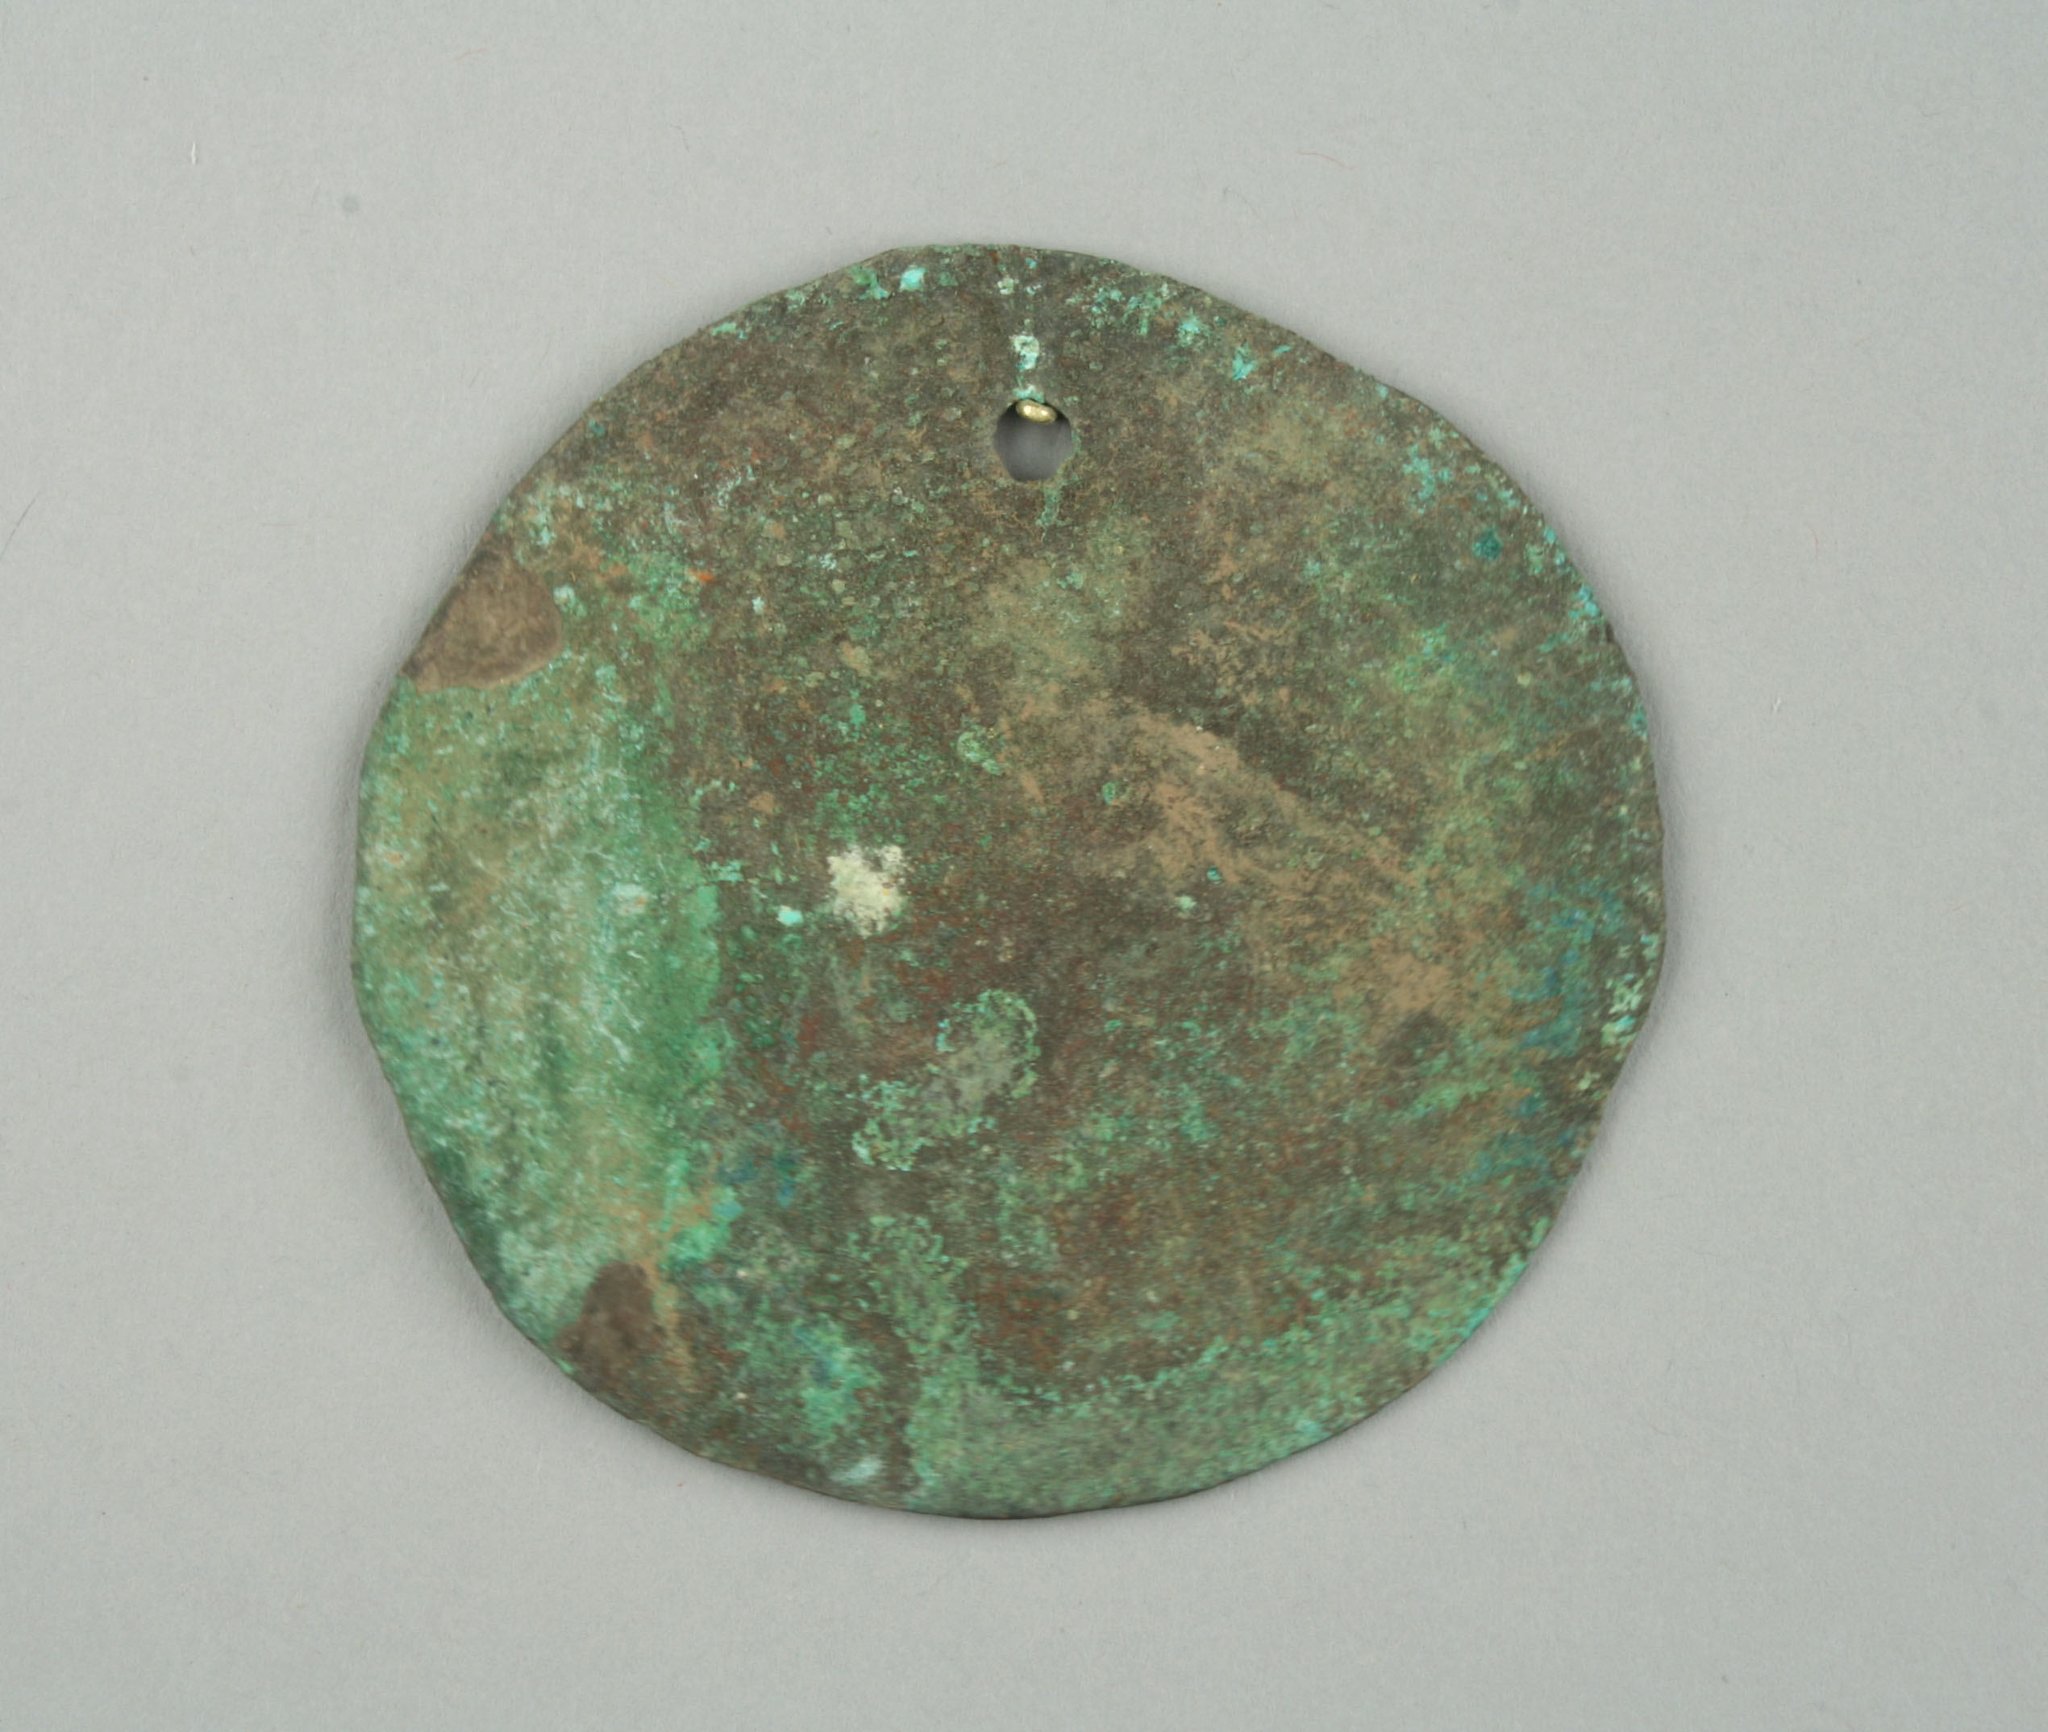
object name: plaque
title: Round Plaque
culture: vicús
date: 300 BCE-200 CE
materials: copper, gilt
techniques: hammering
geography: peru